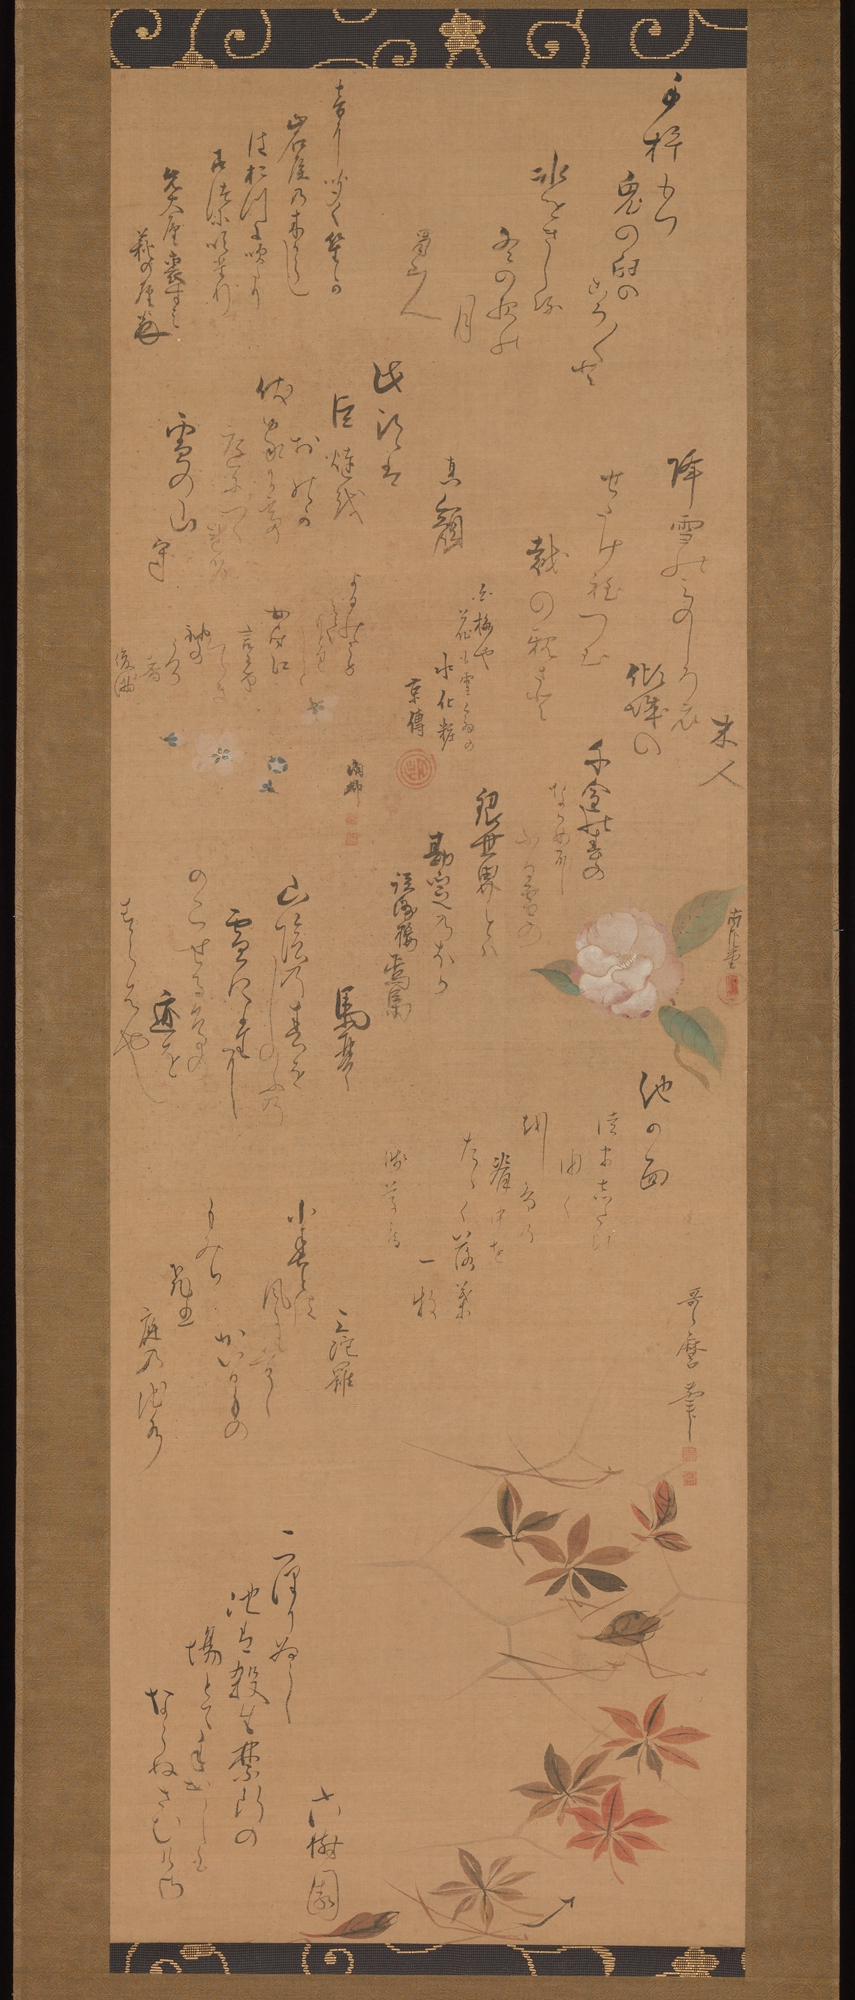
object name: hanging scroll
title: Miscellaneous Paintings and Calligraphy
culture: japanese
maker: utamaro ii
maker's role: artist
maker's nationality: japanese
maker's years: 1750-1850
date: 1801-1806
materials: ink, paper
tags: calligraphy